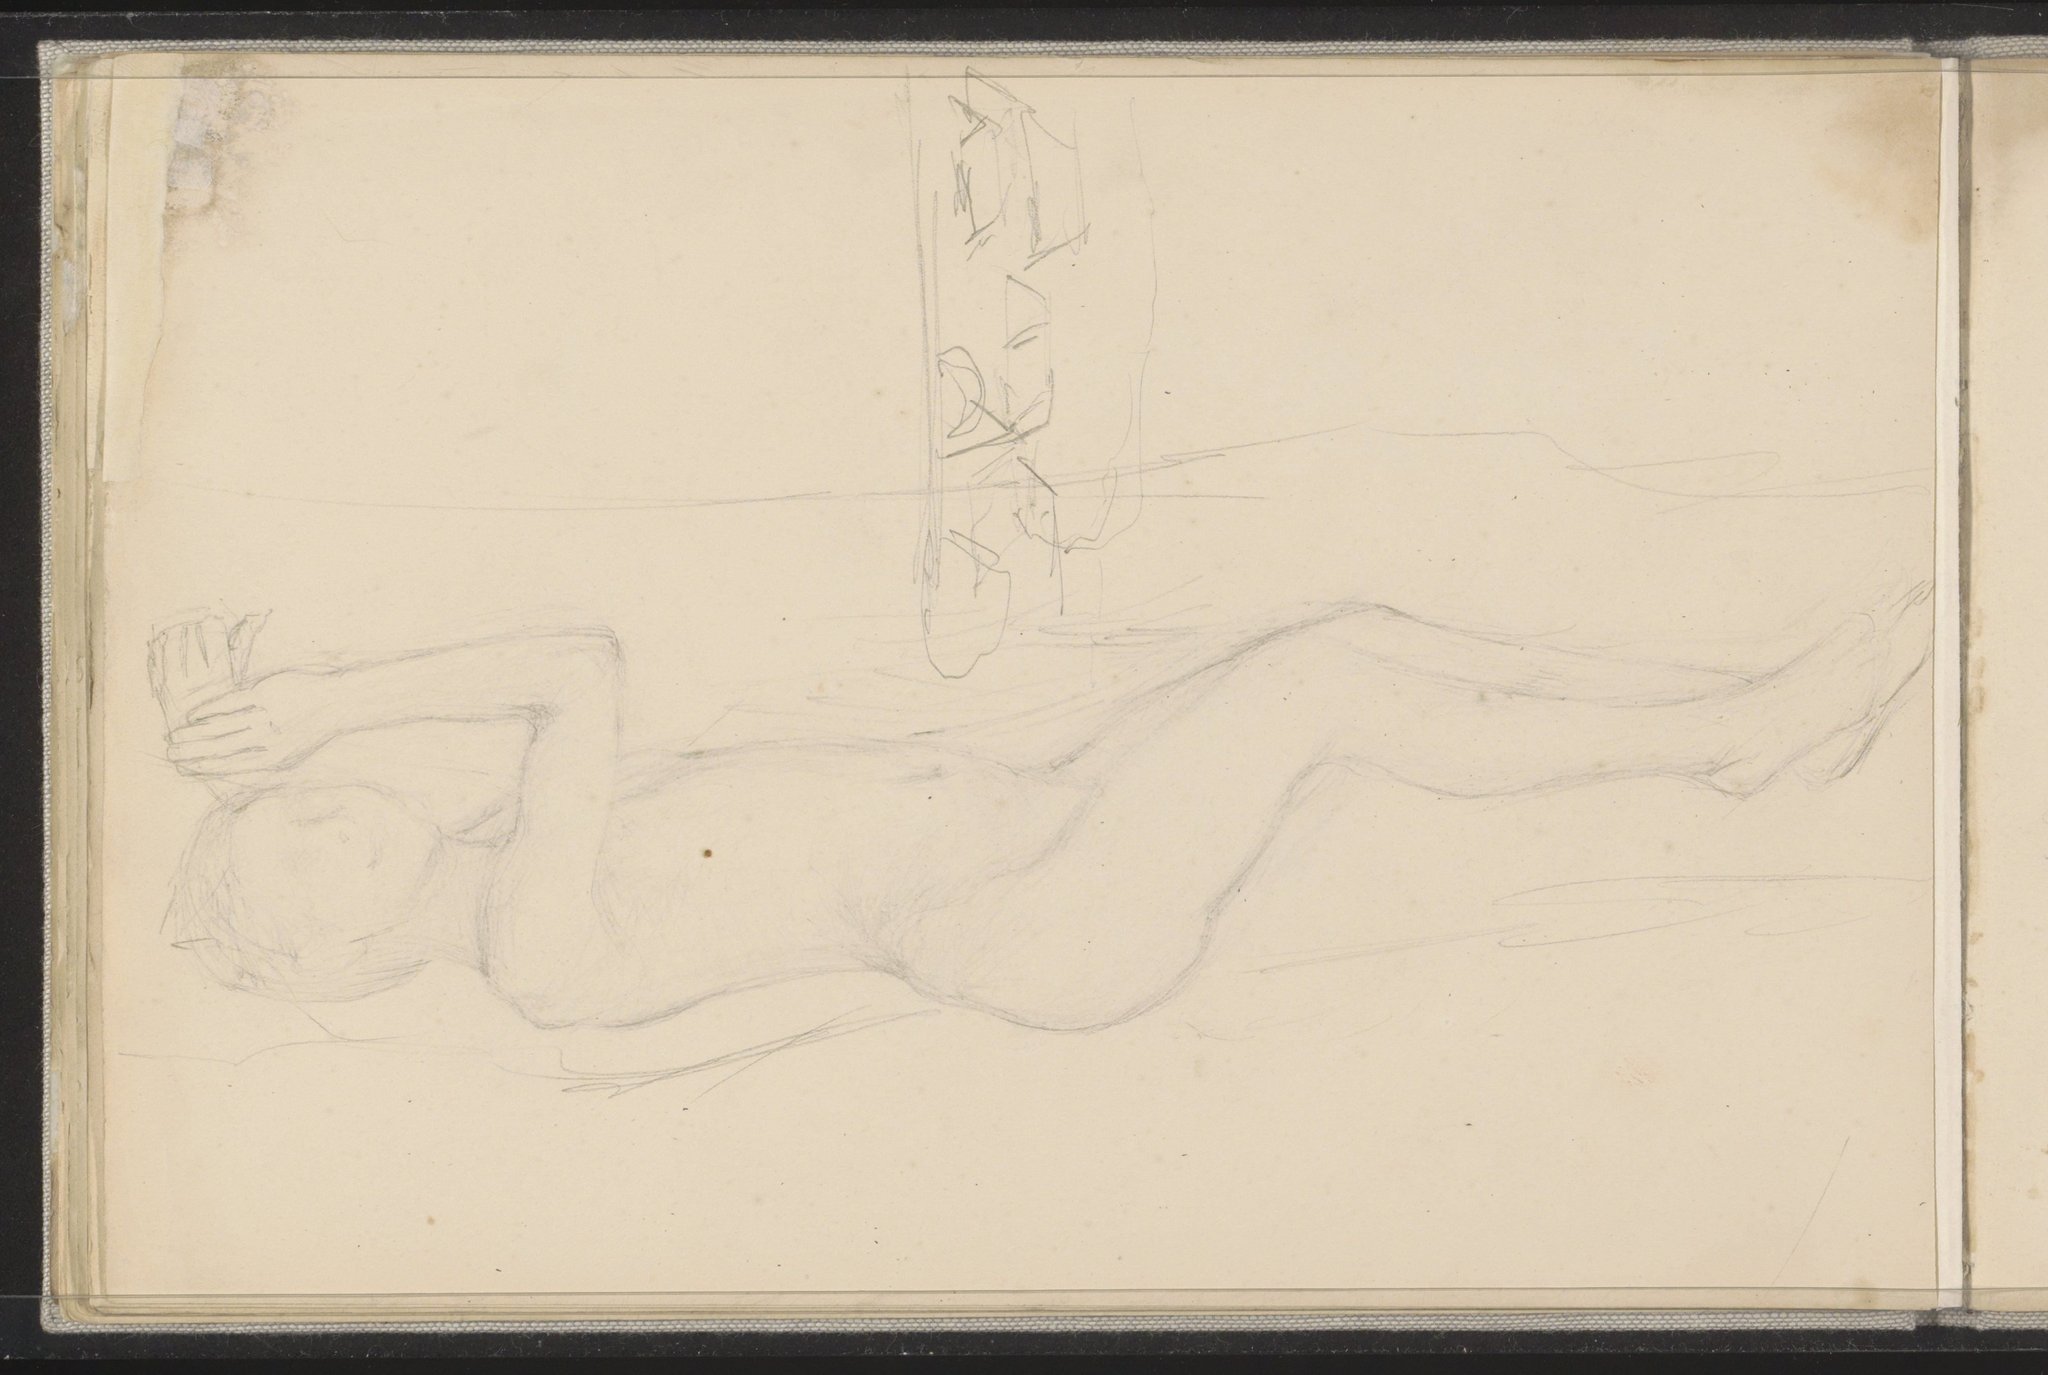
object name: sketchbook leaf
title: Liggend naakt meisje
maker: jozef israëls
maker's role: draughtsman, painter, print maker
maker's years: 1824-1911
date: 1834-1911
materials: paper, pencil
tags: sitting figure (+ nude human being), girl (child between toddler and youth)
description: Blad 23 verso uit een schetsboek met 30 bladen.